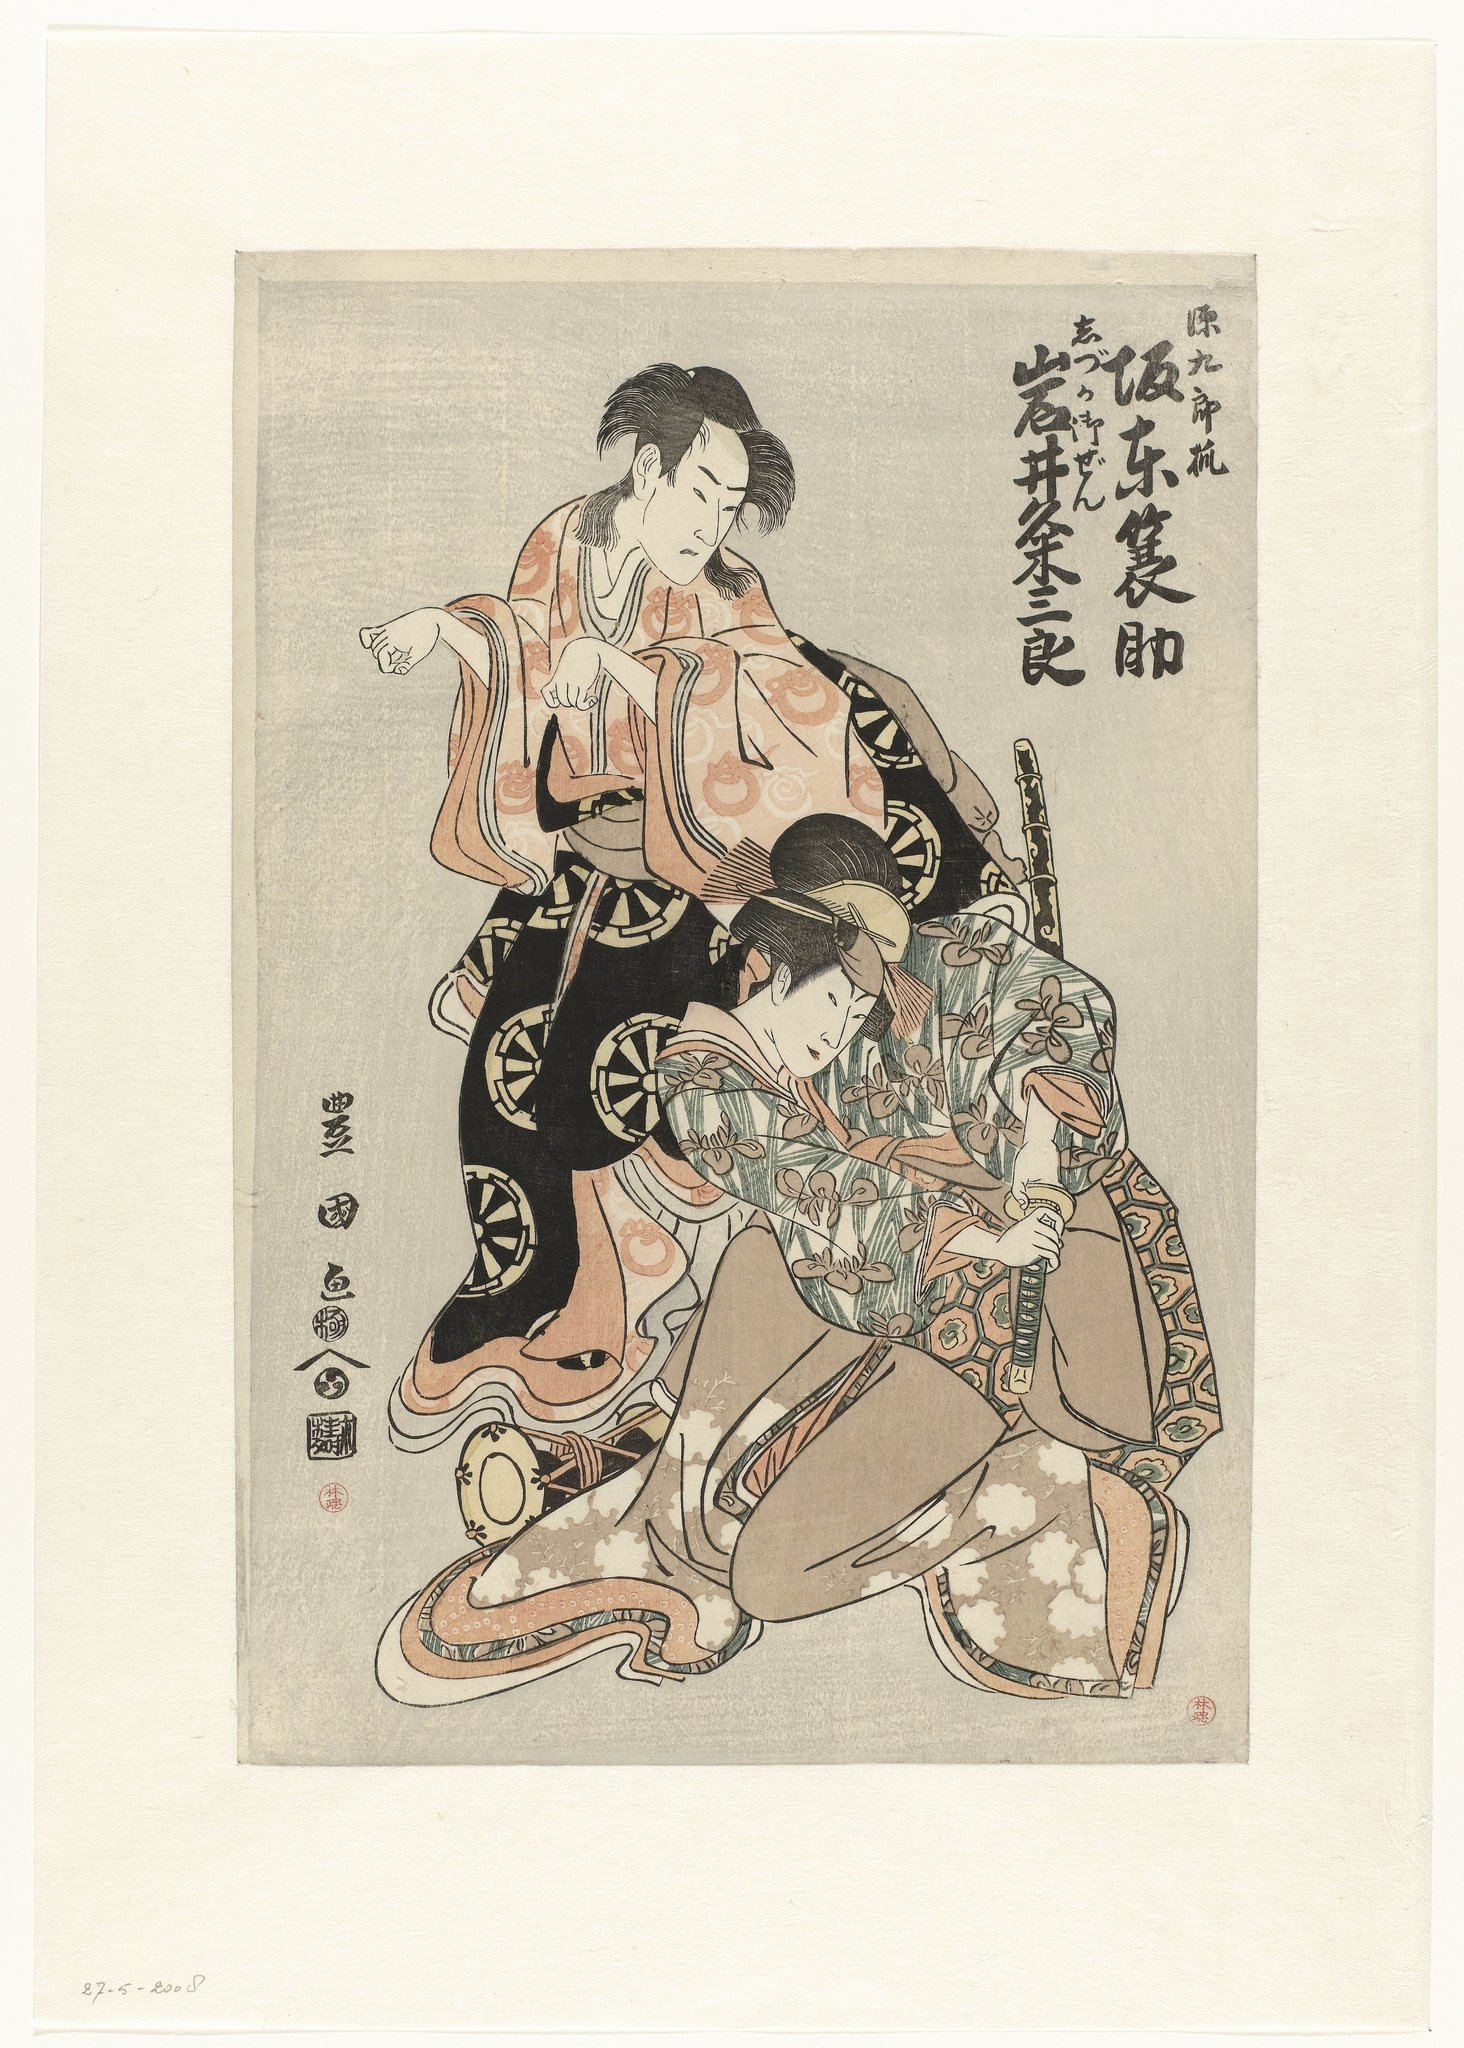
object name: print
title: Twee kabuki acteurs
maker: utagawa toyokuni (i)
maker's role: print maker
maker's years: 1769-1825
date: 1800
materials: paper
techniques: woodcut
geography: japan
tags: hacking and thrusting weapons: sword, portrait of actor, actress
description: De acteurs Bando Minosuke in de rol van Gekuro Kitsune en Iwai Kumesaburo II als Shizuka Gozen, in het kabuki stuk Yoshitsune senbon zakura.